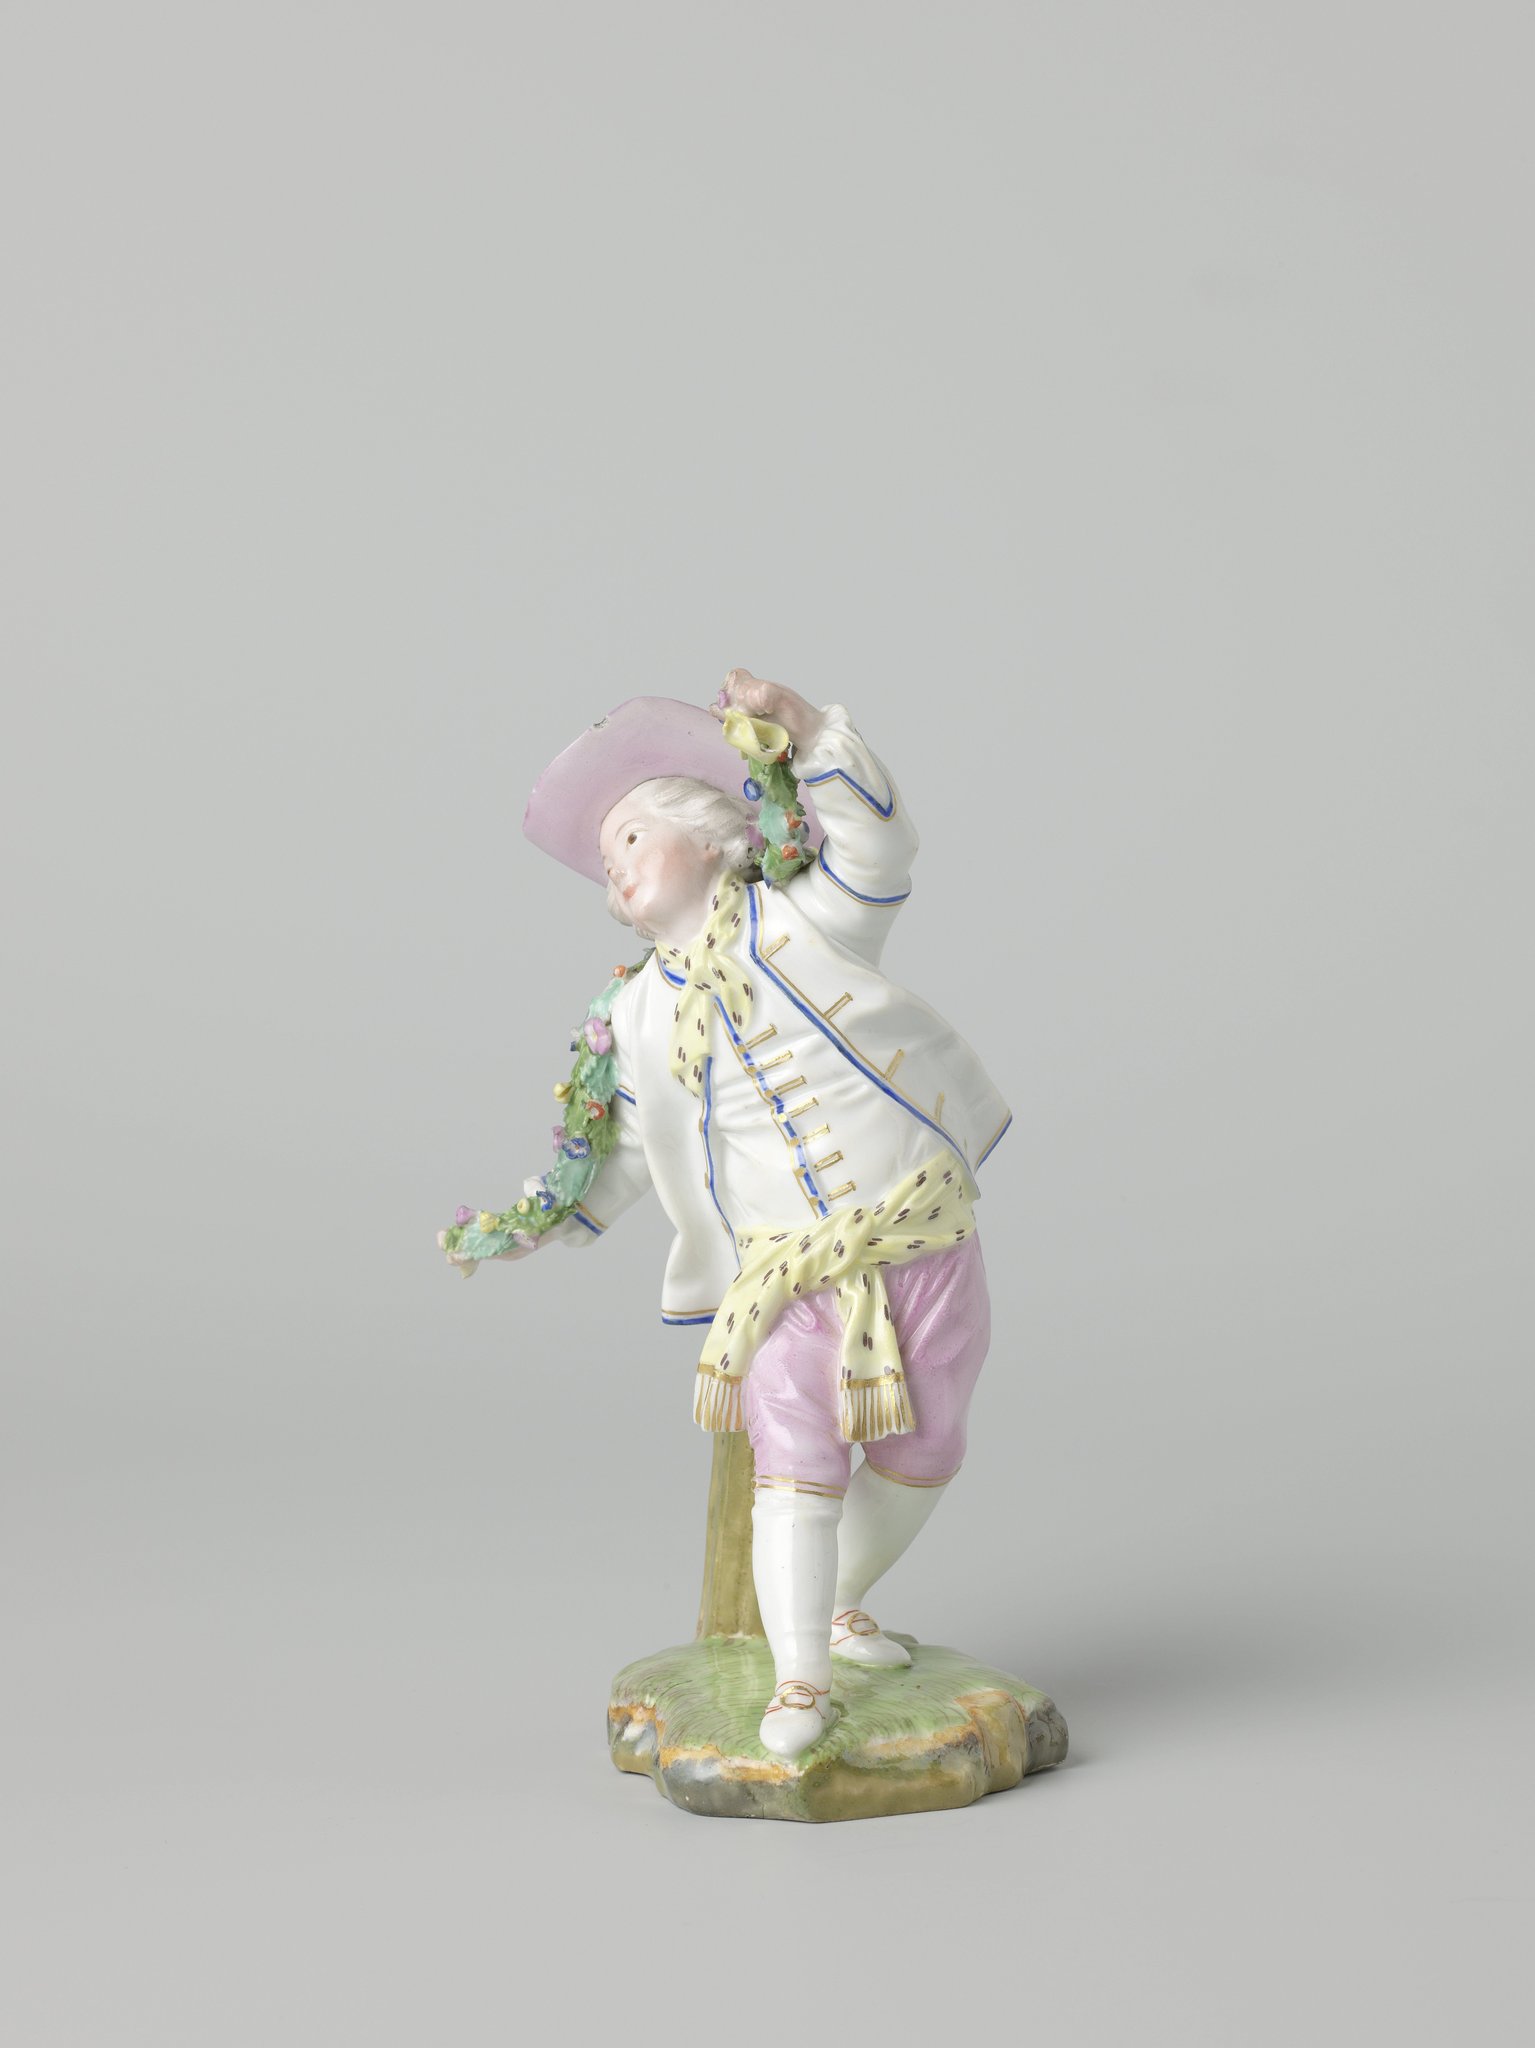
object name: figure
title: Figure of a dancing boy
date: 1767-1775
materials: glaze, gold, paint, porcelain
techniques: firing, forming, gilding, vitrification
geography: höchst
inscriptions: mark: ‘wiel/ S’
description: Two figures. Porcelain. Höchst, c. 1767 - 1775.